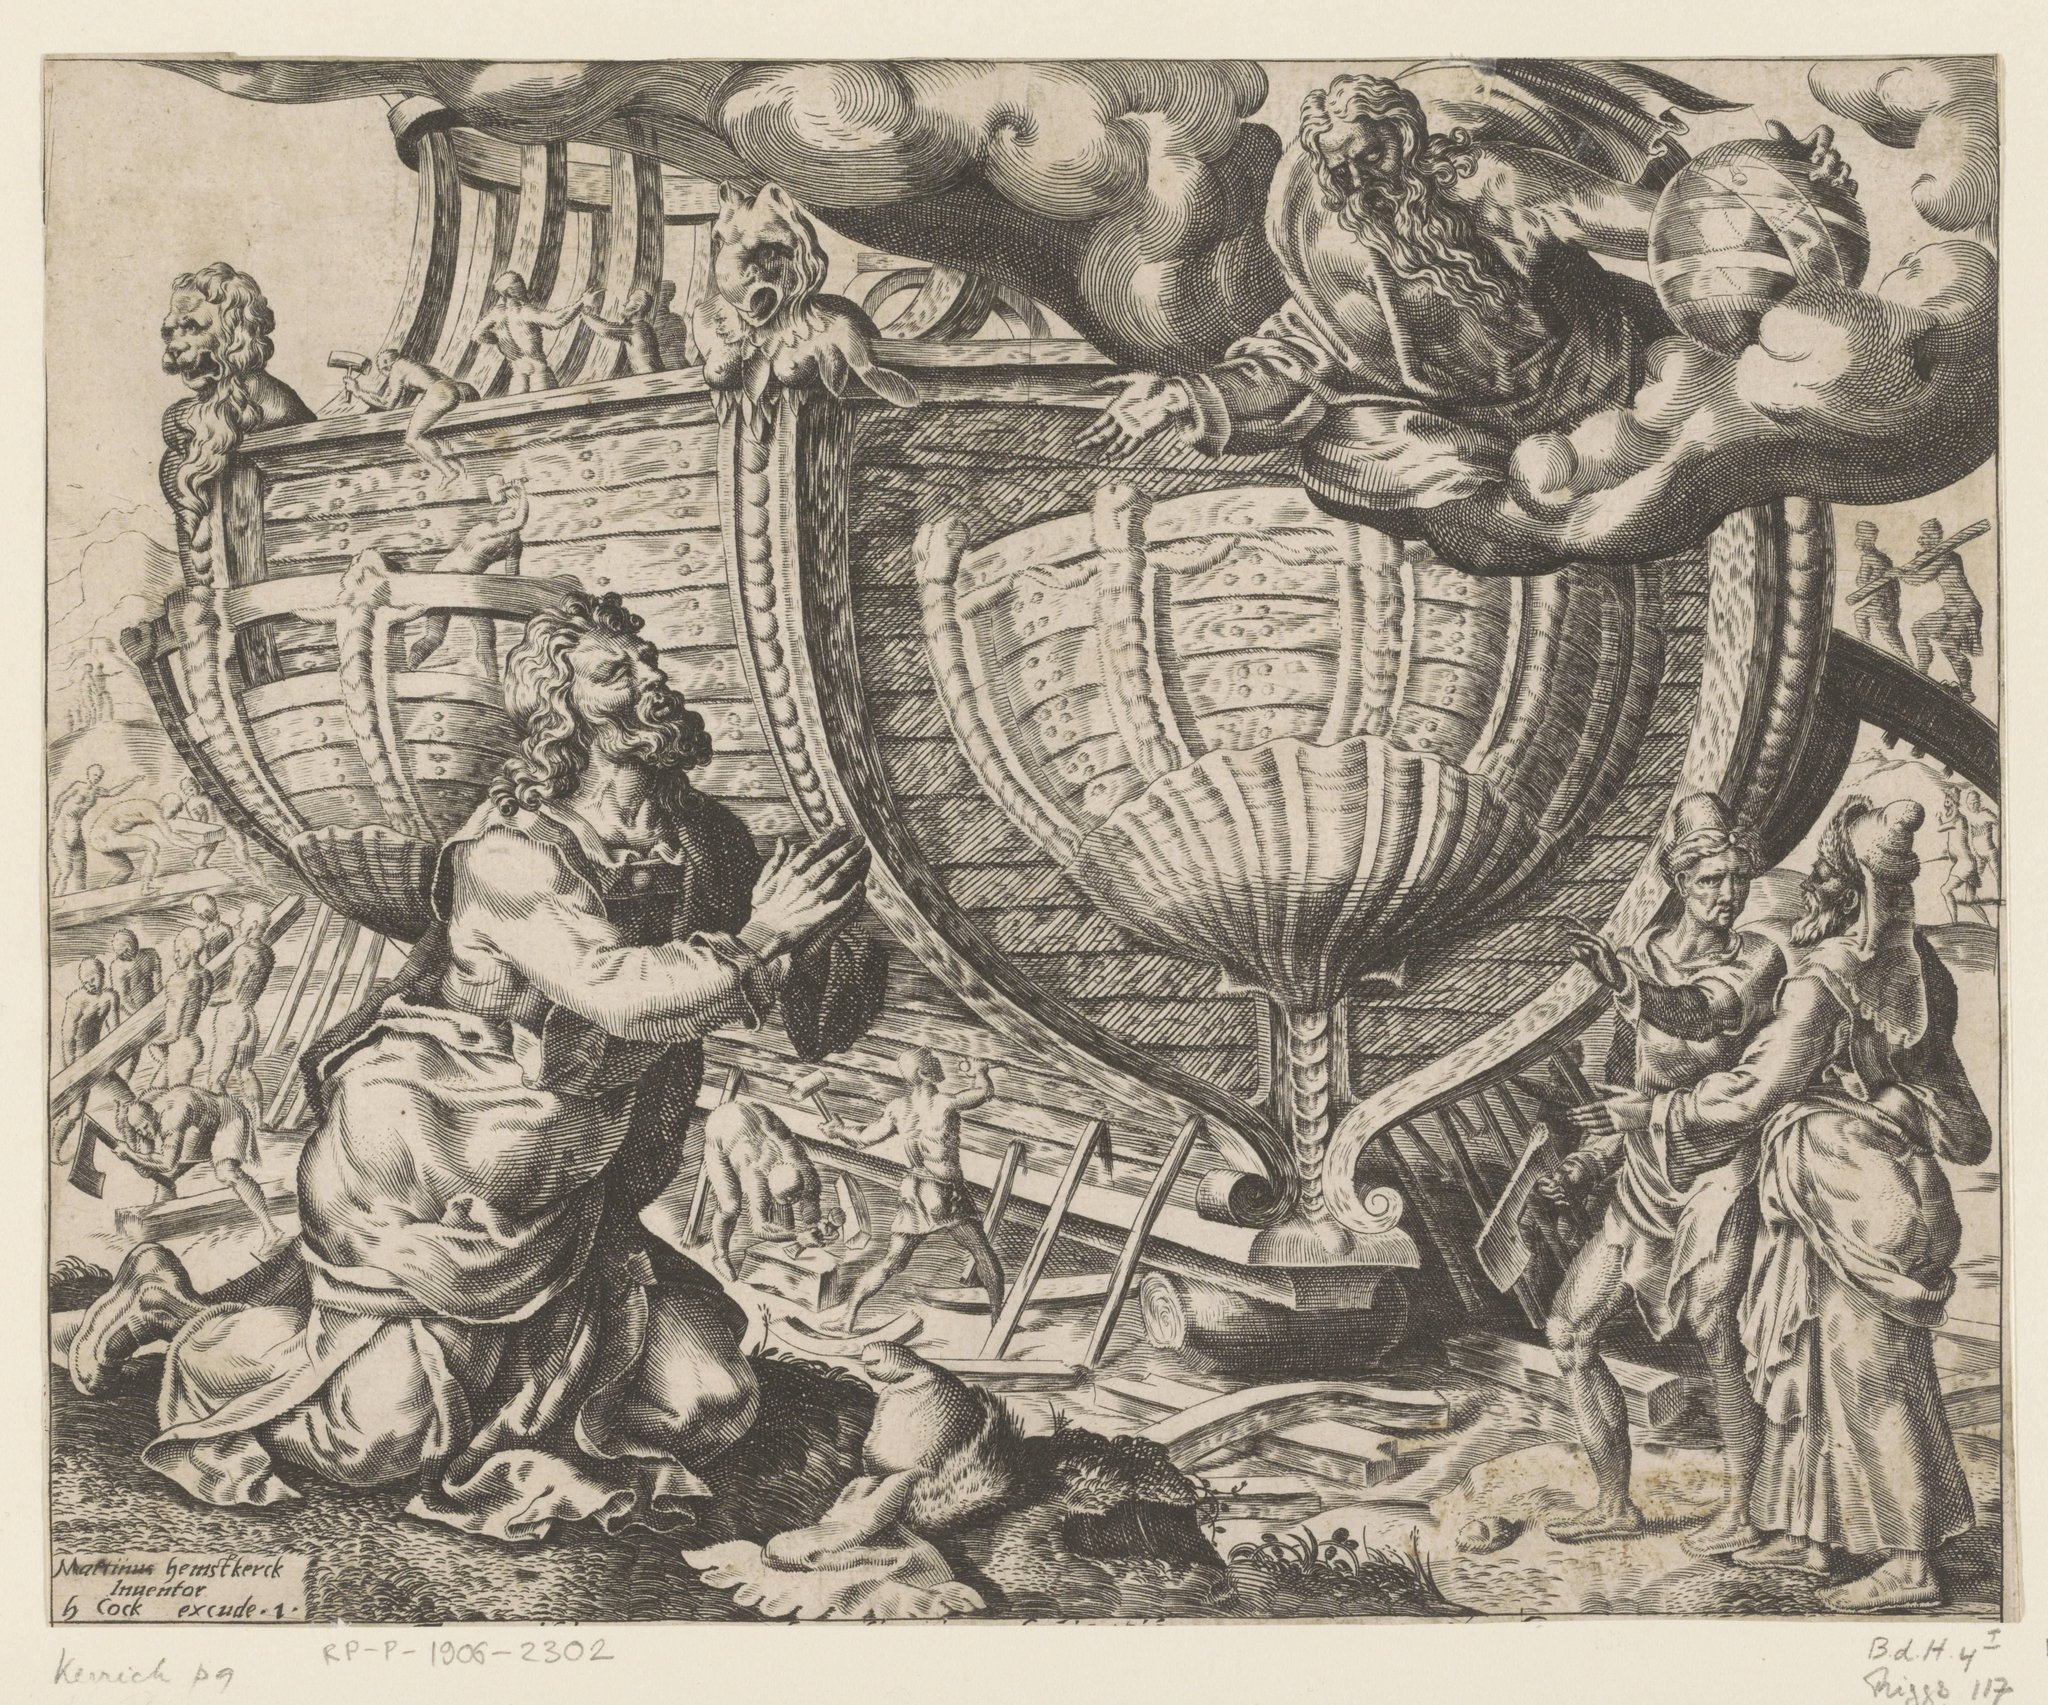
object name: print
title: God draagt Noach op de ark te bouwen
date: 1558-1560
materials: paper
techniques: engraving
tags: building a ship, ship under construction, god the father as bearded old man, usually with crown or tiara or sceptre and/or globe, noah building the ark with the help of his sons, god announces a flood and commands noah to build an ark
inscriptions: signature: ‘Martinus hemstkerck / Inventor’, caption: ‘Fac tibi arcam de lignis levigatis gen. cap. 6’, address: ‘h Cock excude.1’, collector's mark: Lugt 2228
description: Links op de voorgrond zit Noach geknield, de handen gevouwen. Voor hem verschijnt God als oude man met wereldbol in de linkerhand, op een wolk. Op de achtergrond zijn timmerlieden druk bezig de ark te bouwen.